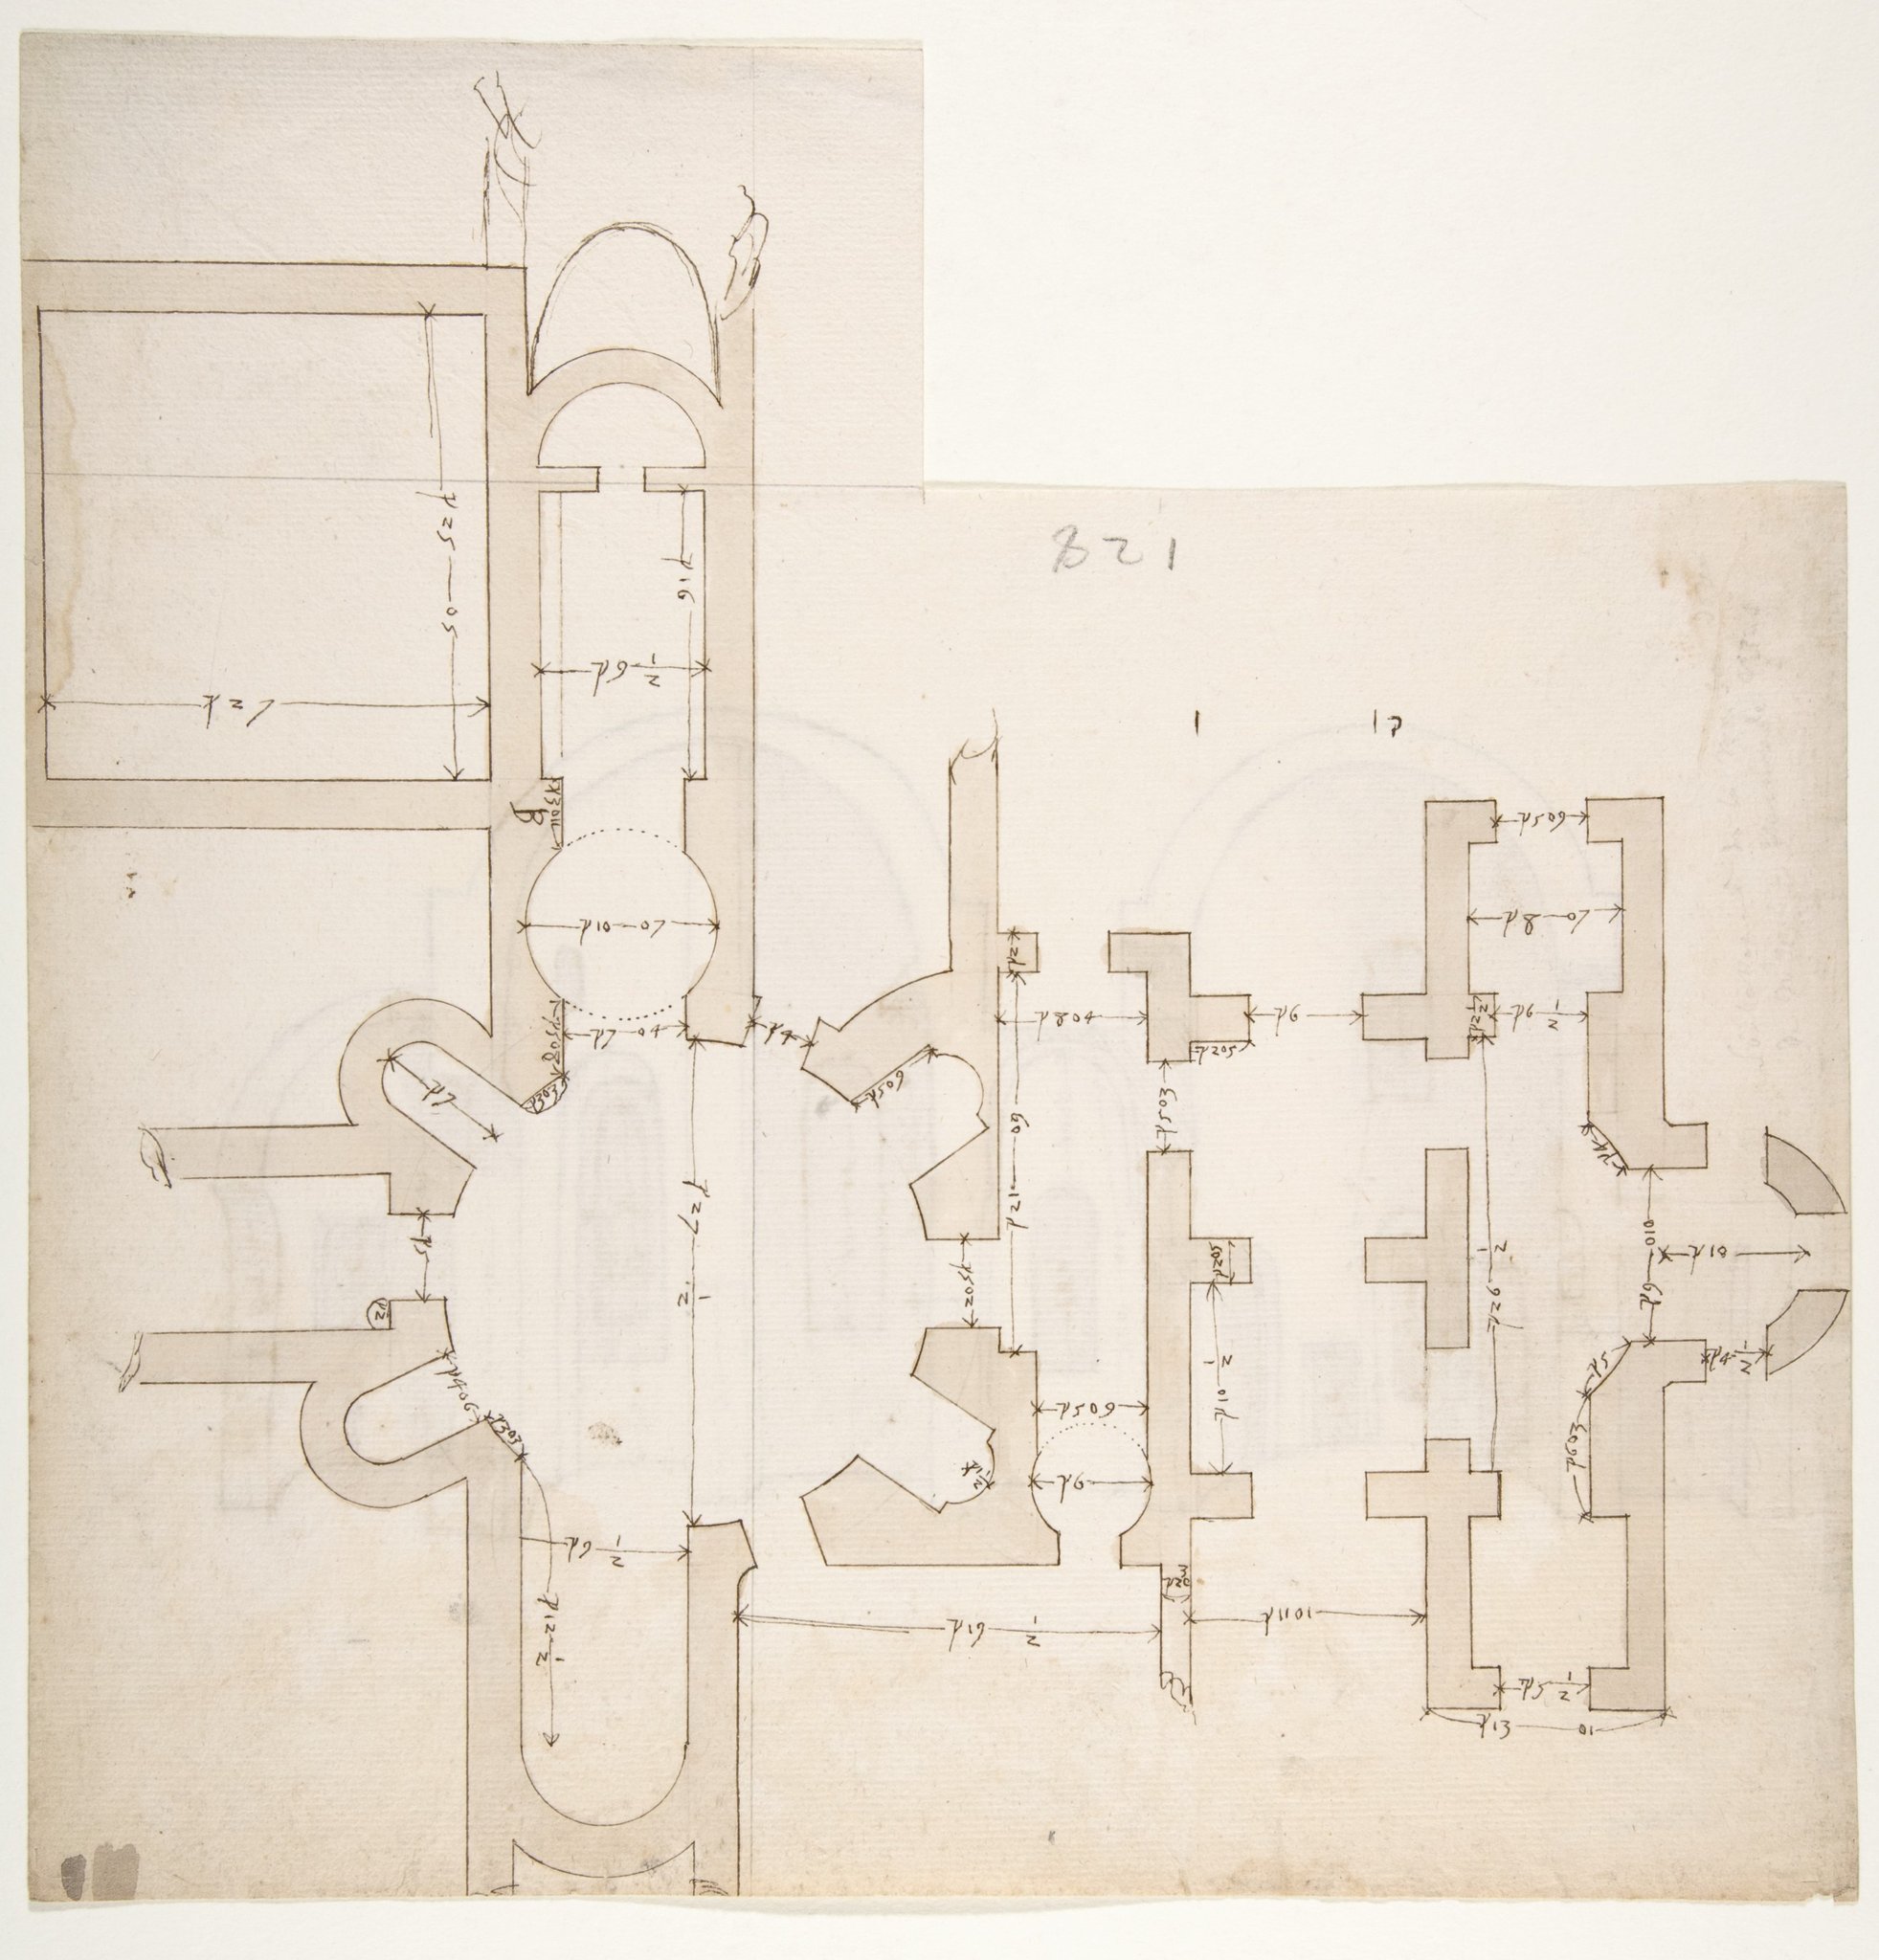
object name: collection ornament architecture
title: S. Giovanni Laterano, Centocelle, plan (recto) S. Giovanni Laterano, Centocelle, section (verso)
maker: anonymous, french, 16th century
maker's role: draftsman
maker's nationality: french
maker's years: 1500-1600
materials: chalk, ink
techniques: incising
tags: architecture